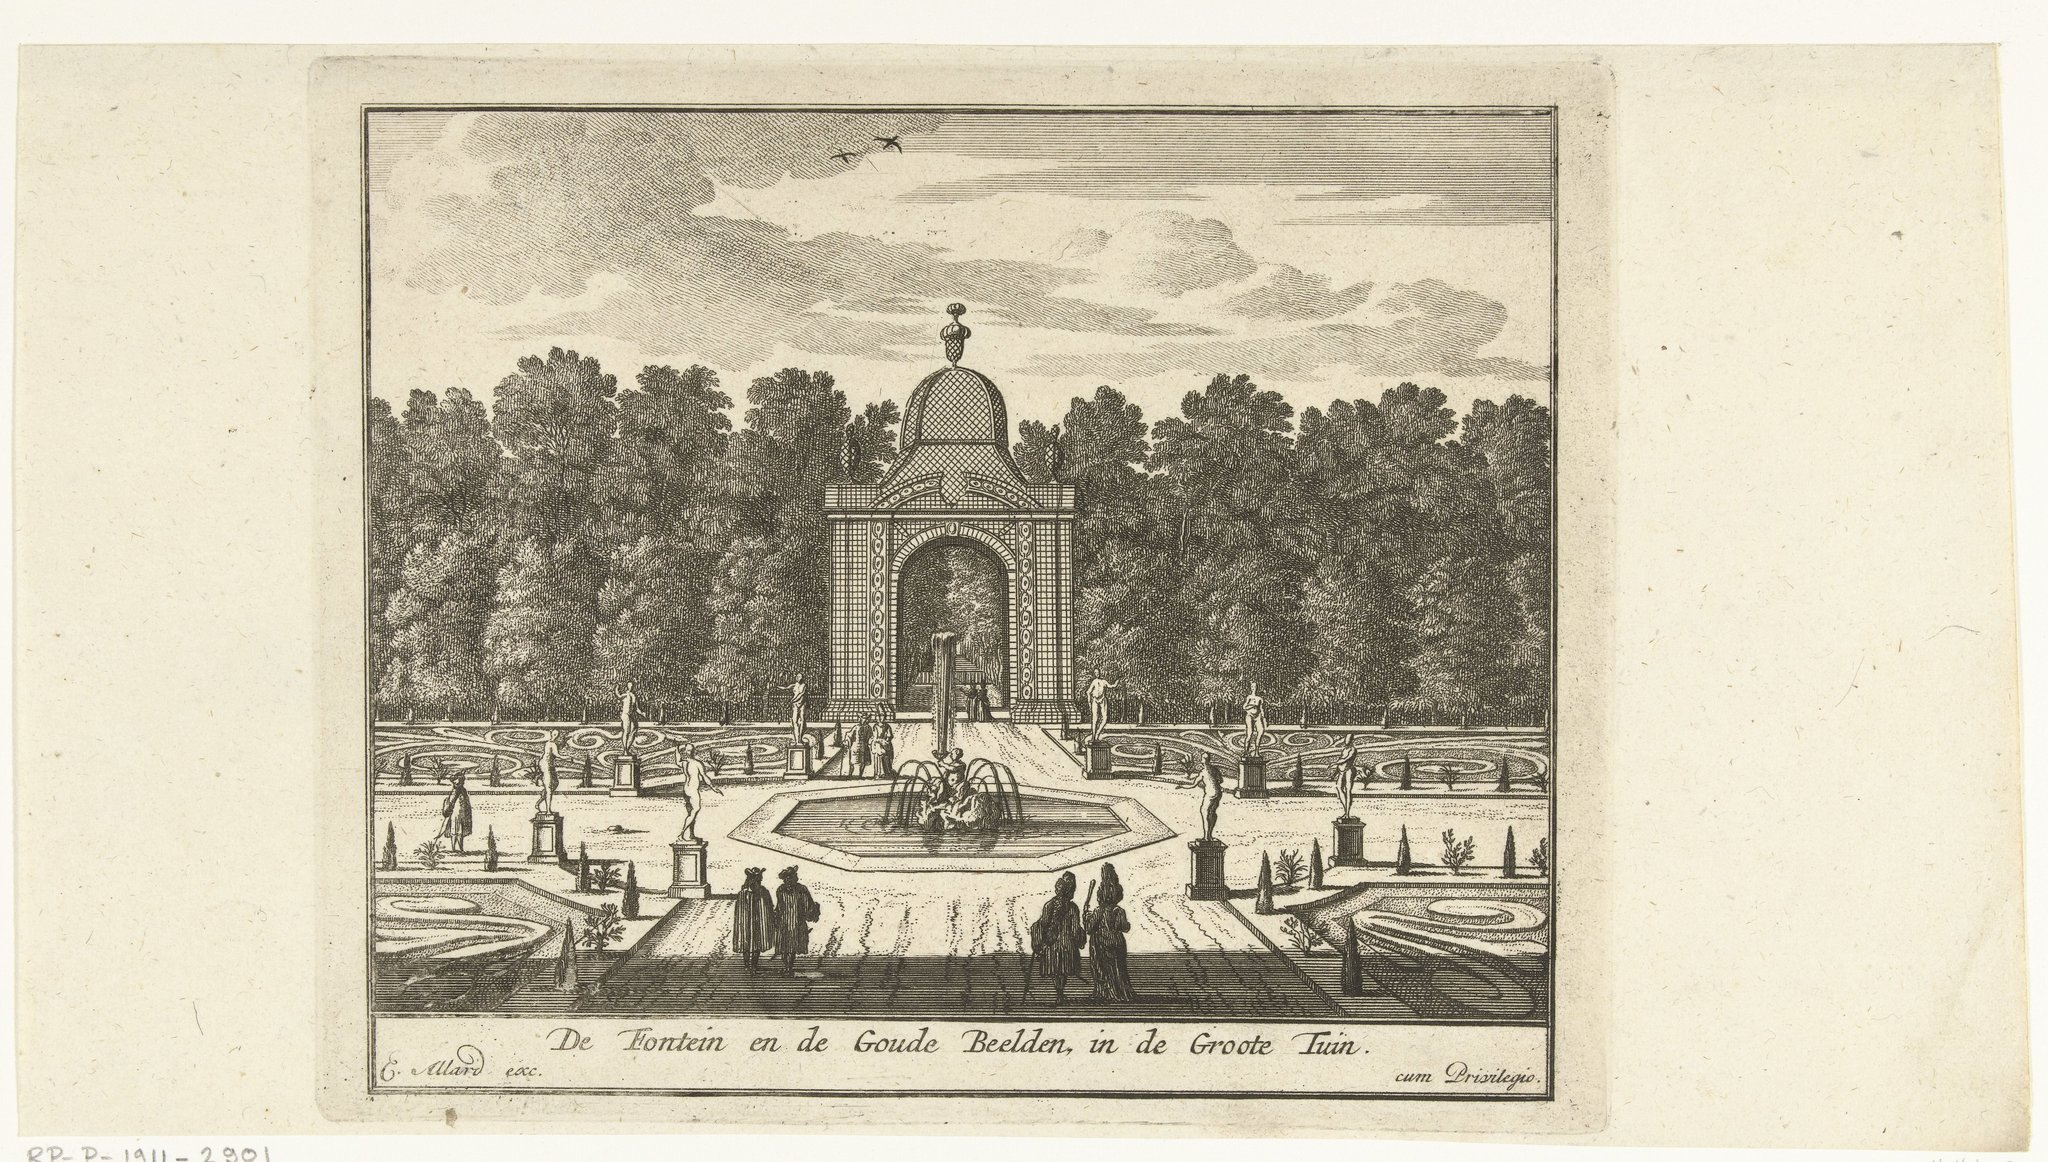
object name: print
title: Hollands Lustpark besluitende zyn Britannische majesteits hof-gebouw tot Honslaardyk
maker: carel allard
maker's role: print maker, publisher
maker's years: 1648-1709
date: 1689-1702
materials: paper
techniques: engraving, etching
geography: amsterdam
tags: garden fountain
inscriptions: collector's mark: Lugt 2228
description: Barokke tuin met beelden. In het midden van de voorstelling staat een fontein. Op de lanen flaneren groepjes wandelaars. Op de achtergrond een stenen poort. Prent uit een serie van zeventien prenten van Paleis Honselaarsdijk.